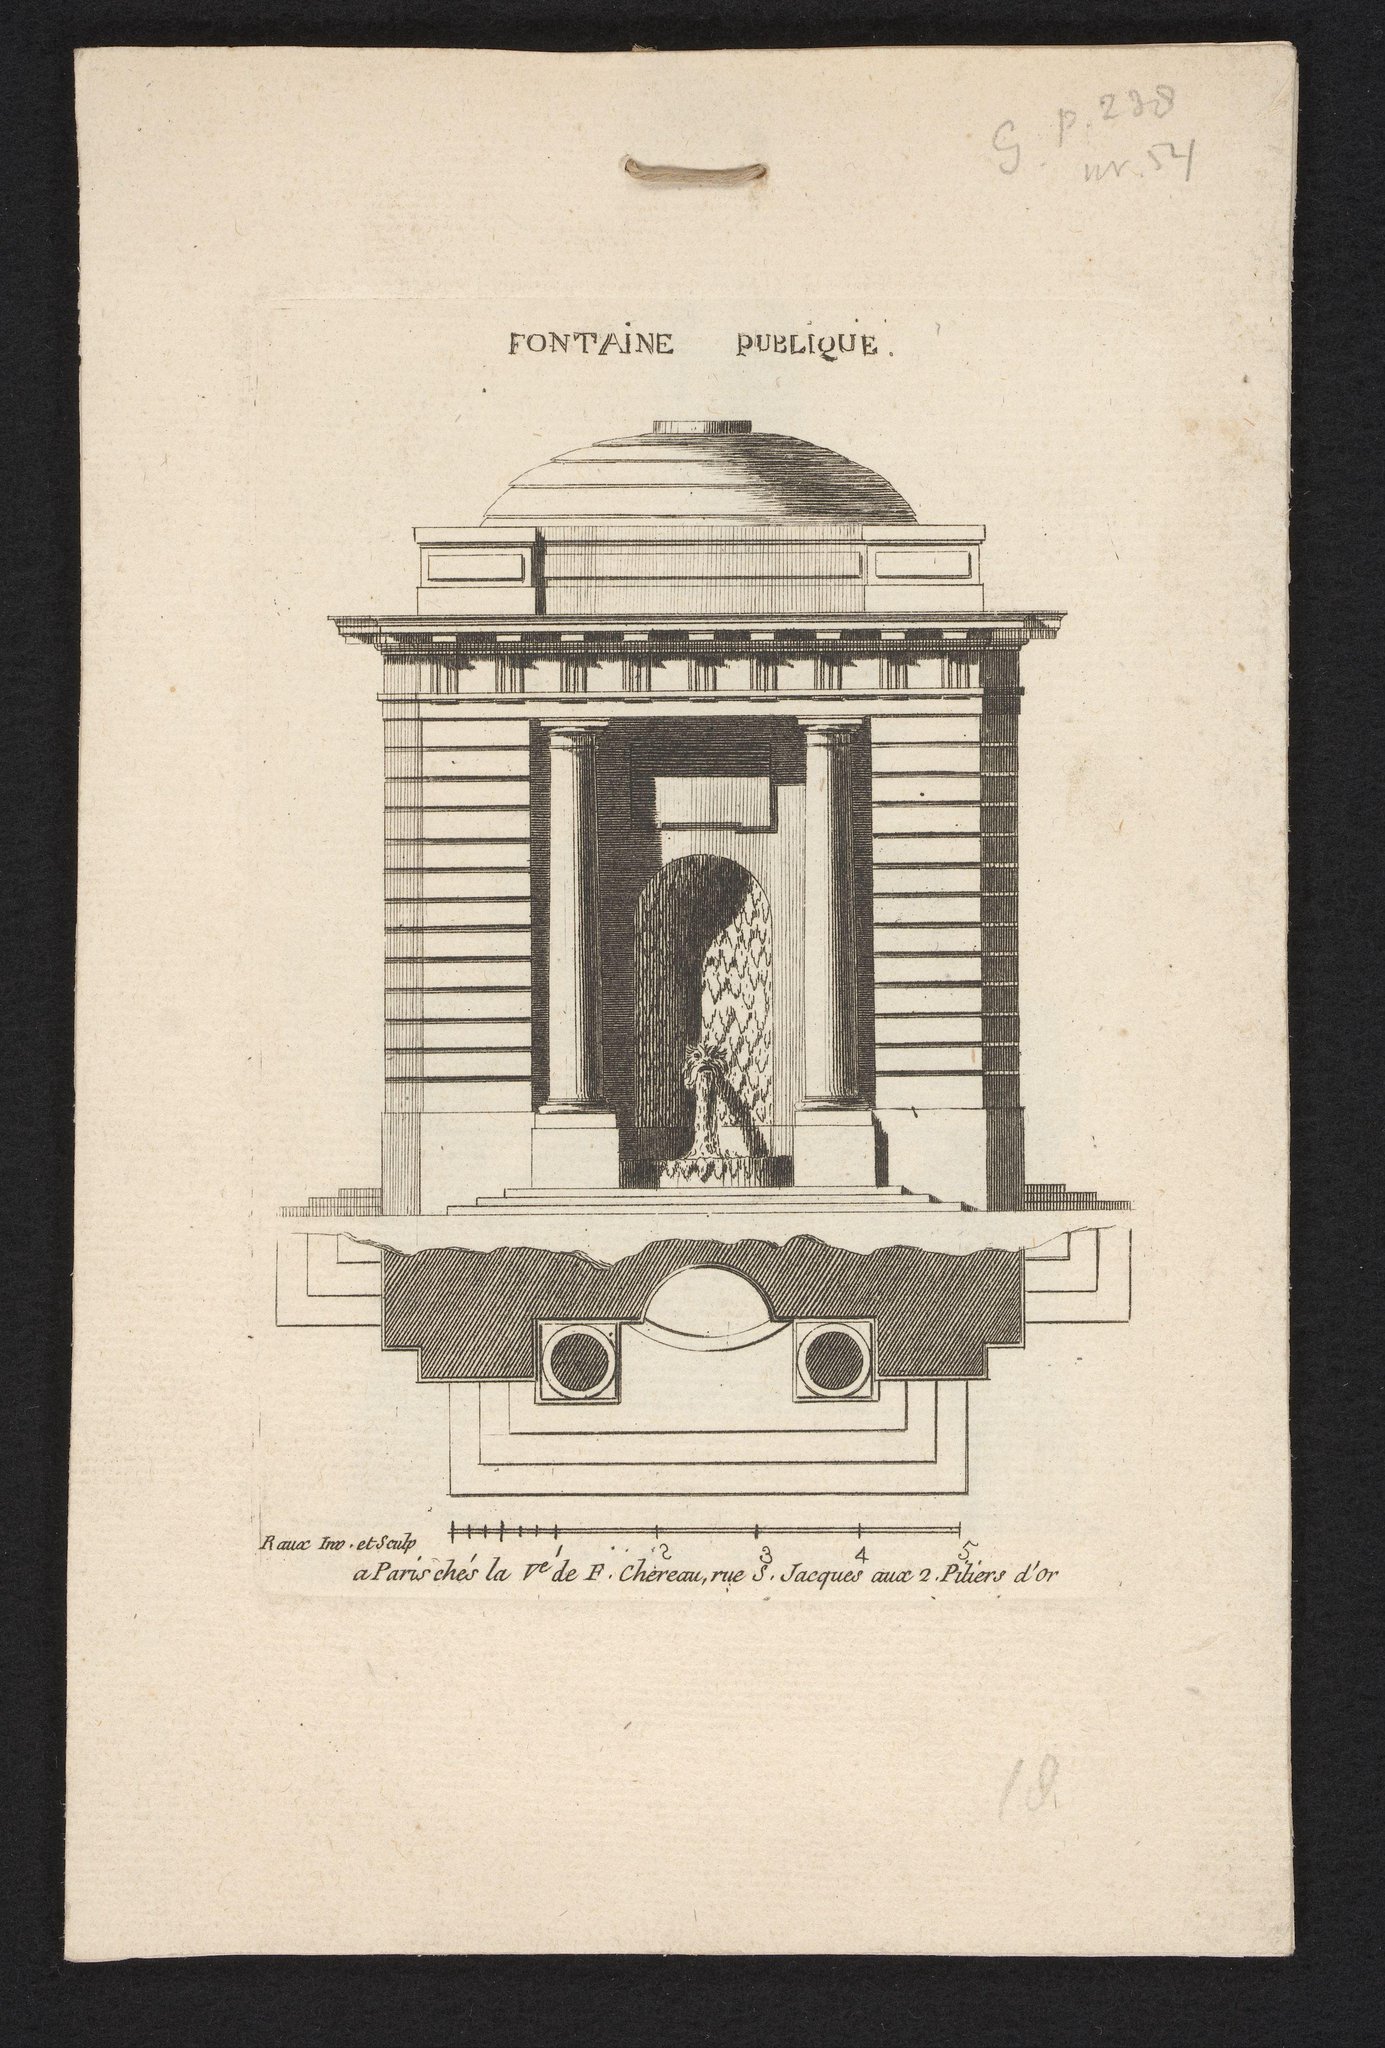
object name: print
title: Fontein in koepelgebouw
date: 1755-1768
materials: paper, fiber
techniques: etching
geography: paris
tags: other architectural details (cupola), ornamental fountain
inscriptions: collector's mark: Lugt 2760, collector's mark: Lugt 2228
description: Fontein met masker tussen twee zuilen in een classicistisch koepelgebouw met trappartijen.